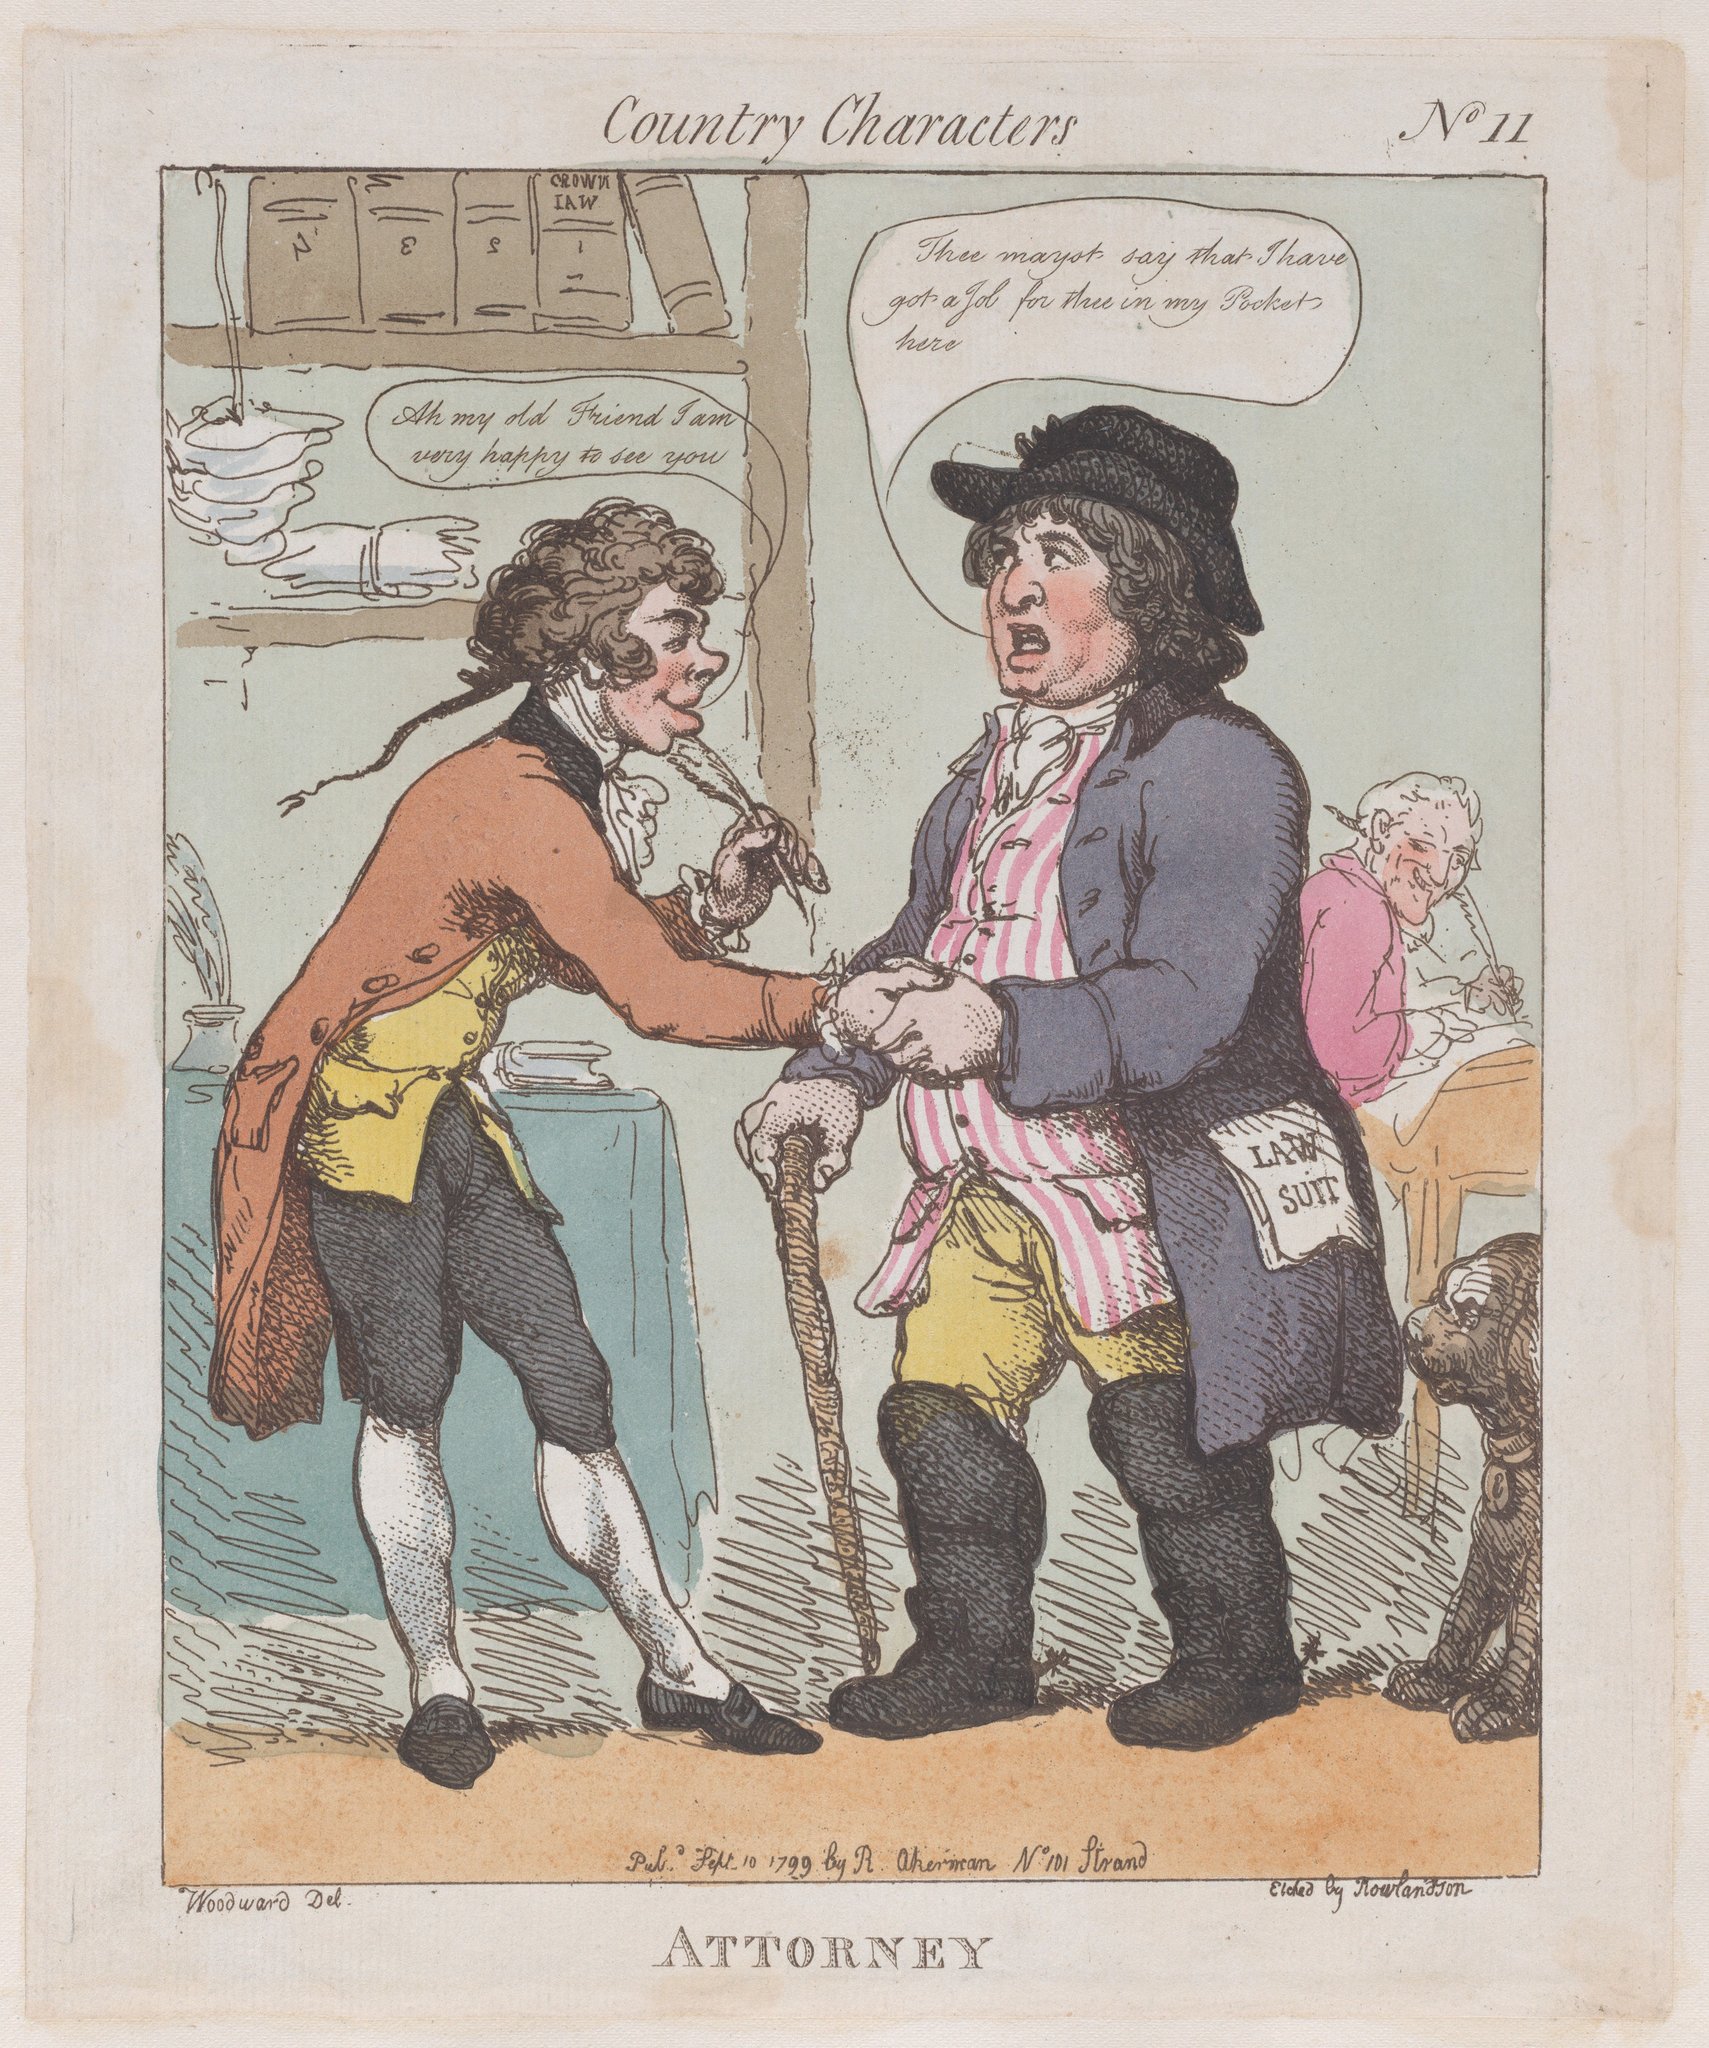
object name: print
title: Attorney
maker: thomas rowlandson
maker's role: artist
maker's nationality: british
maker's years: 1757-1827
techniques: etching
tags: satire,men,dogs